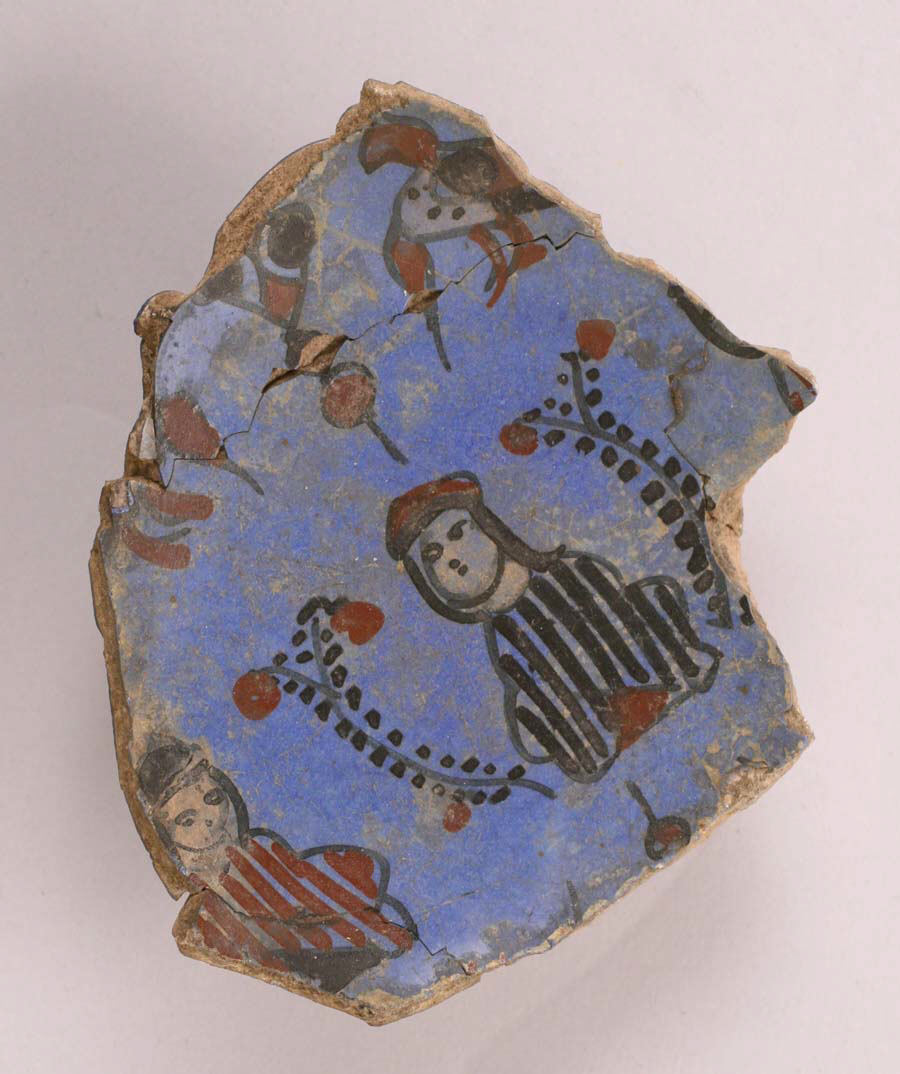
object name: fragment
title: Fragment of a Bowl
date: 1101-1300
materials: stonepaste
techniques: overglaze, painting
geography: iran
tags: human figures